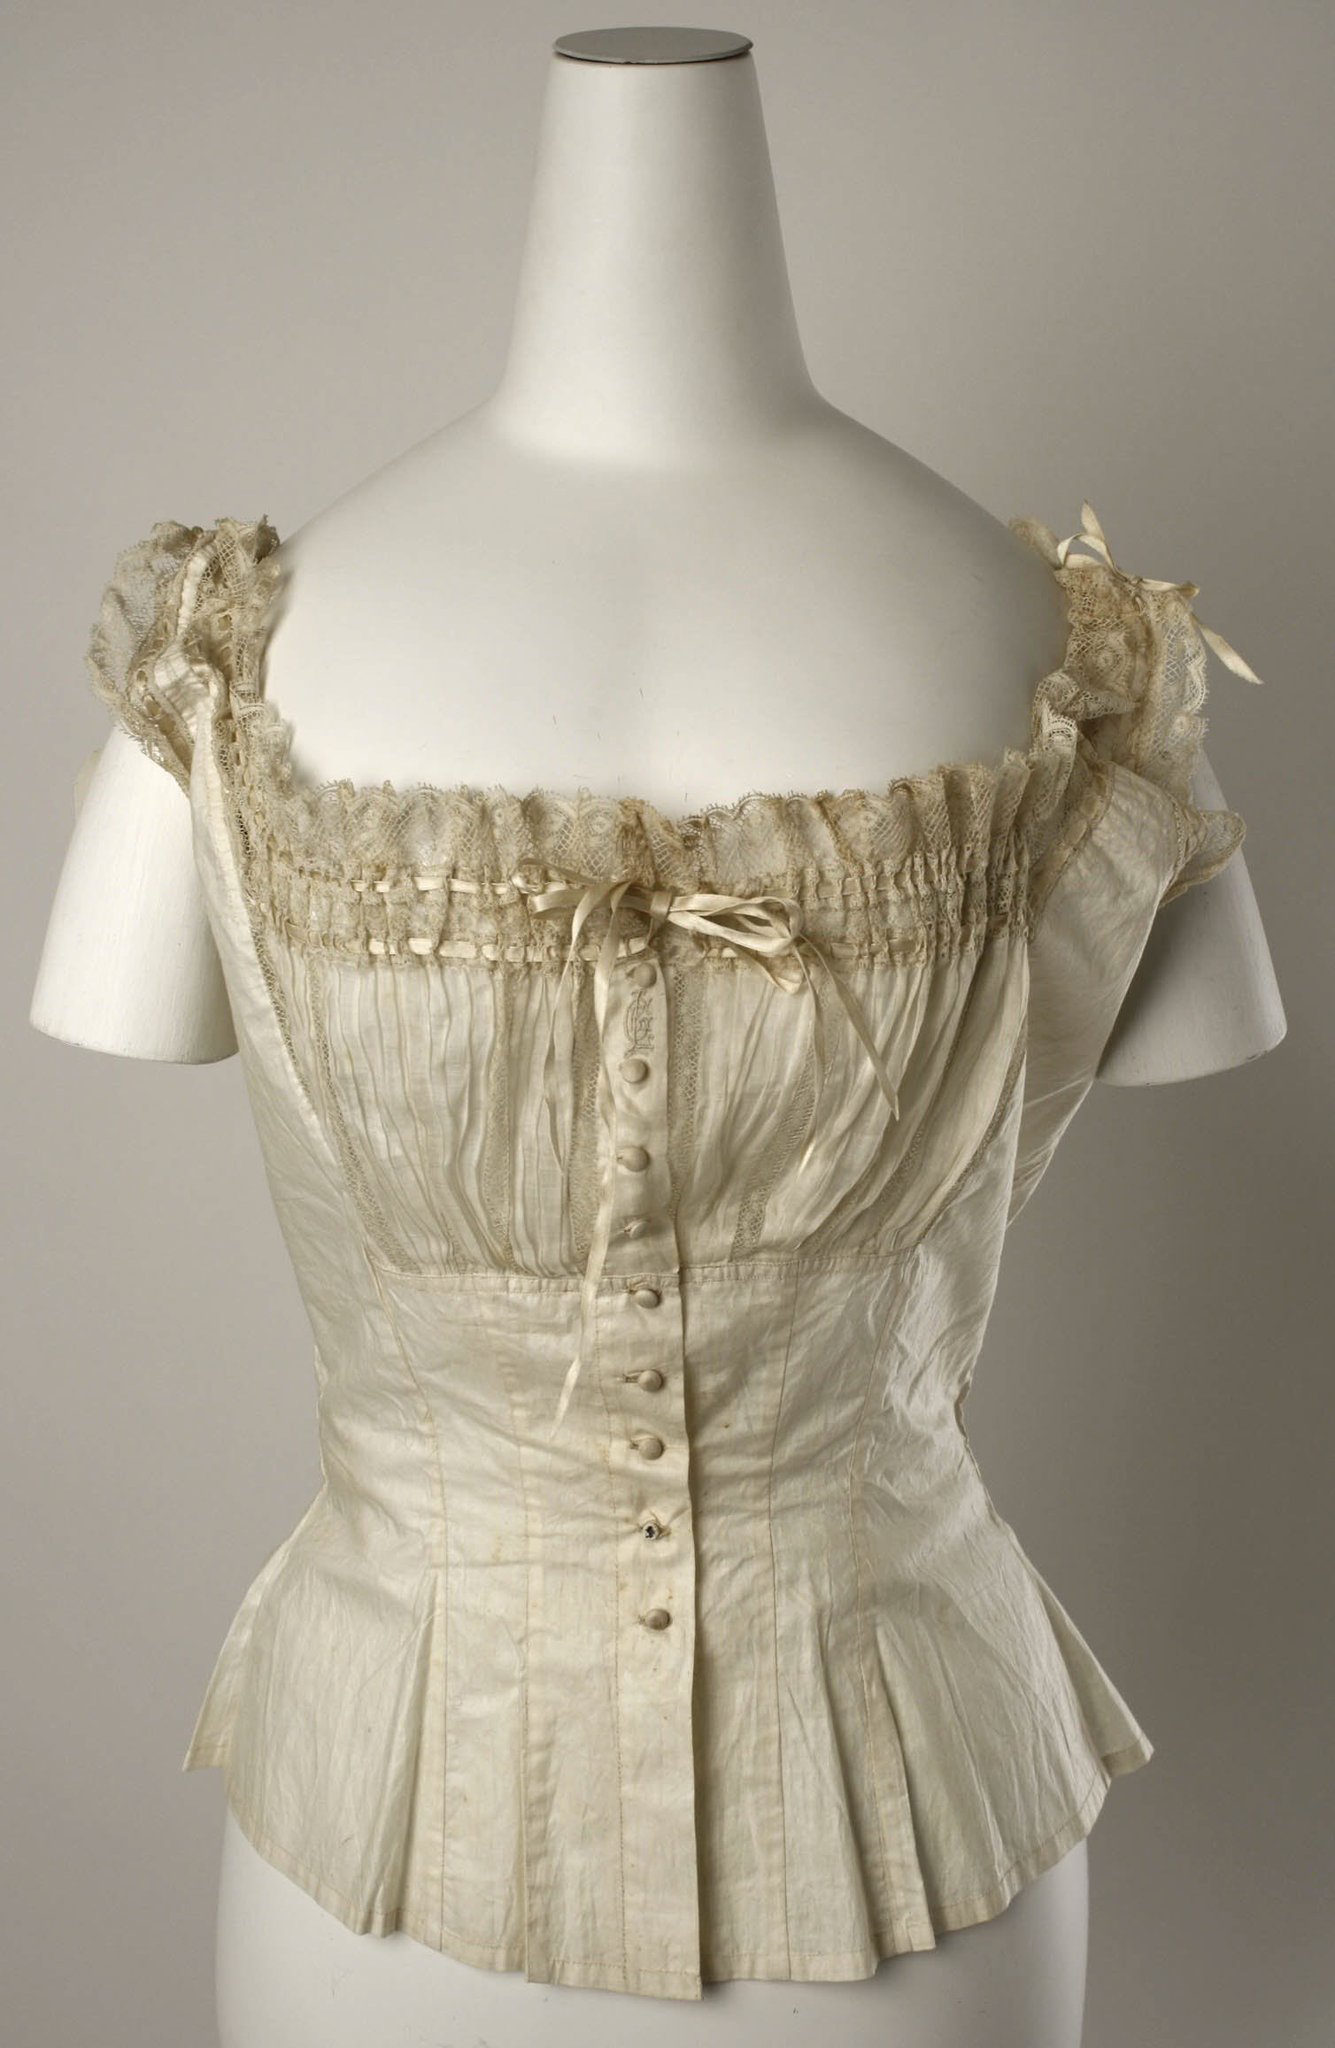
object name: wedding lingerie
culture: american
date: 1880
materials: cotton, silk